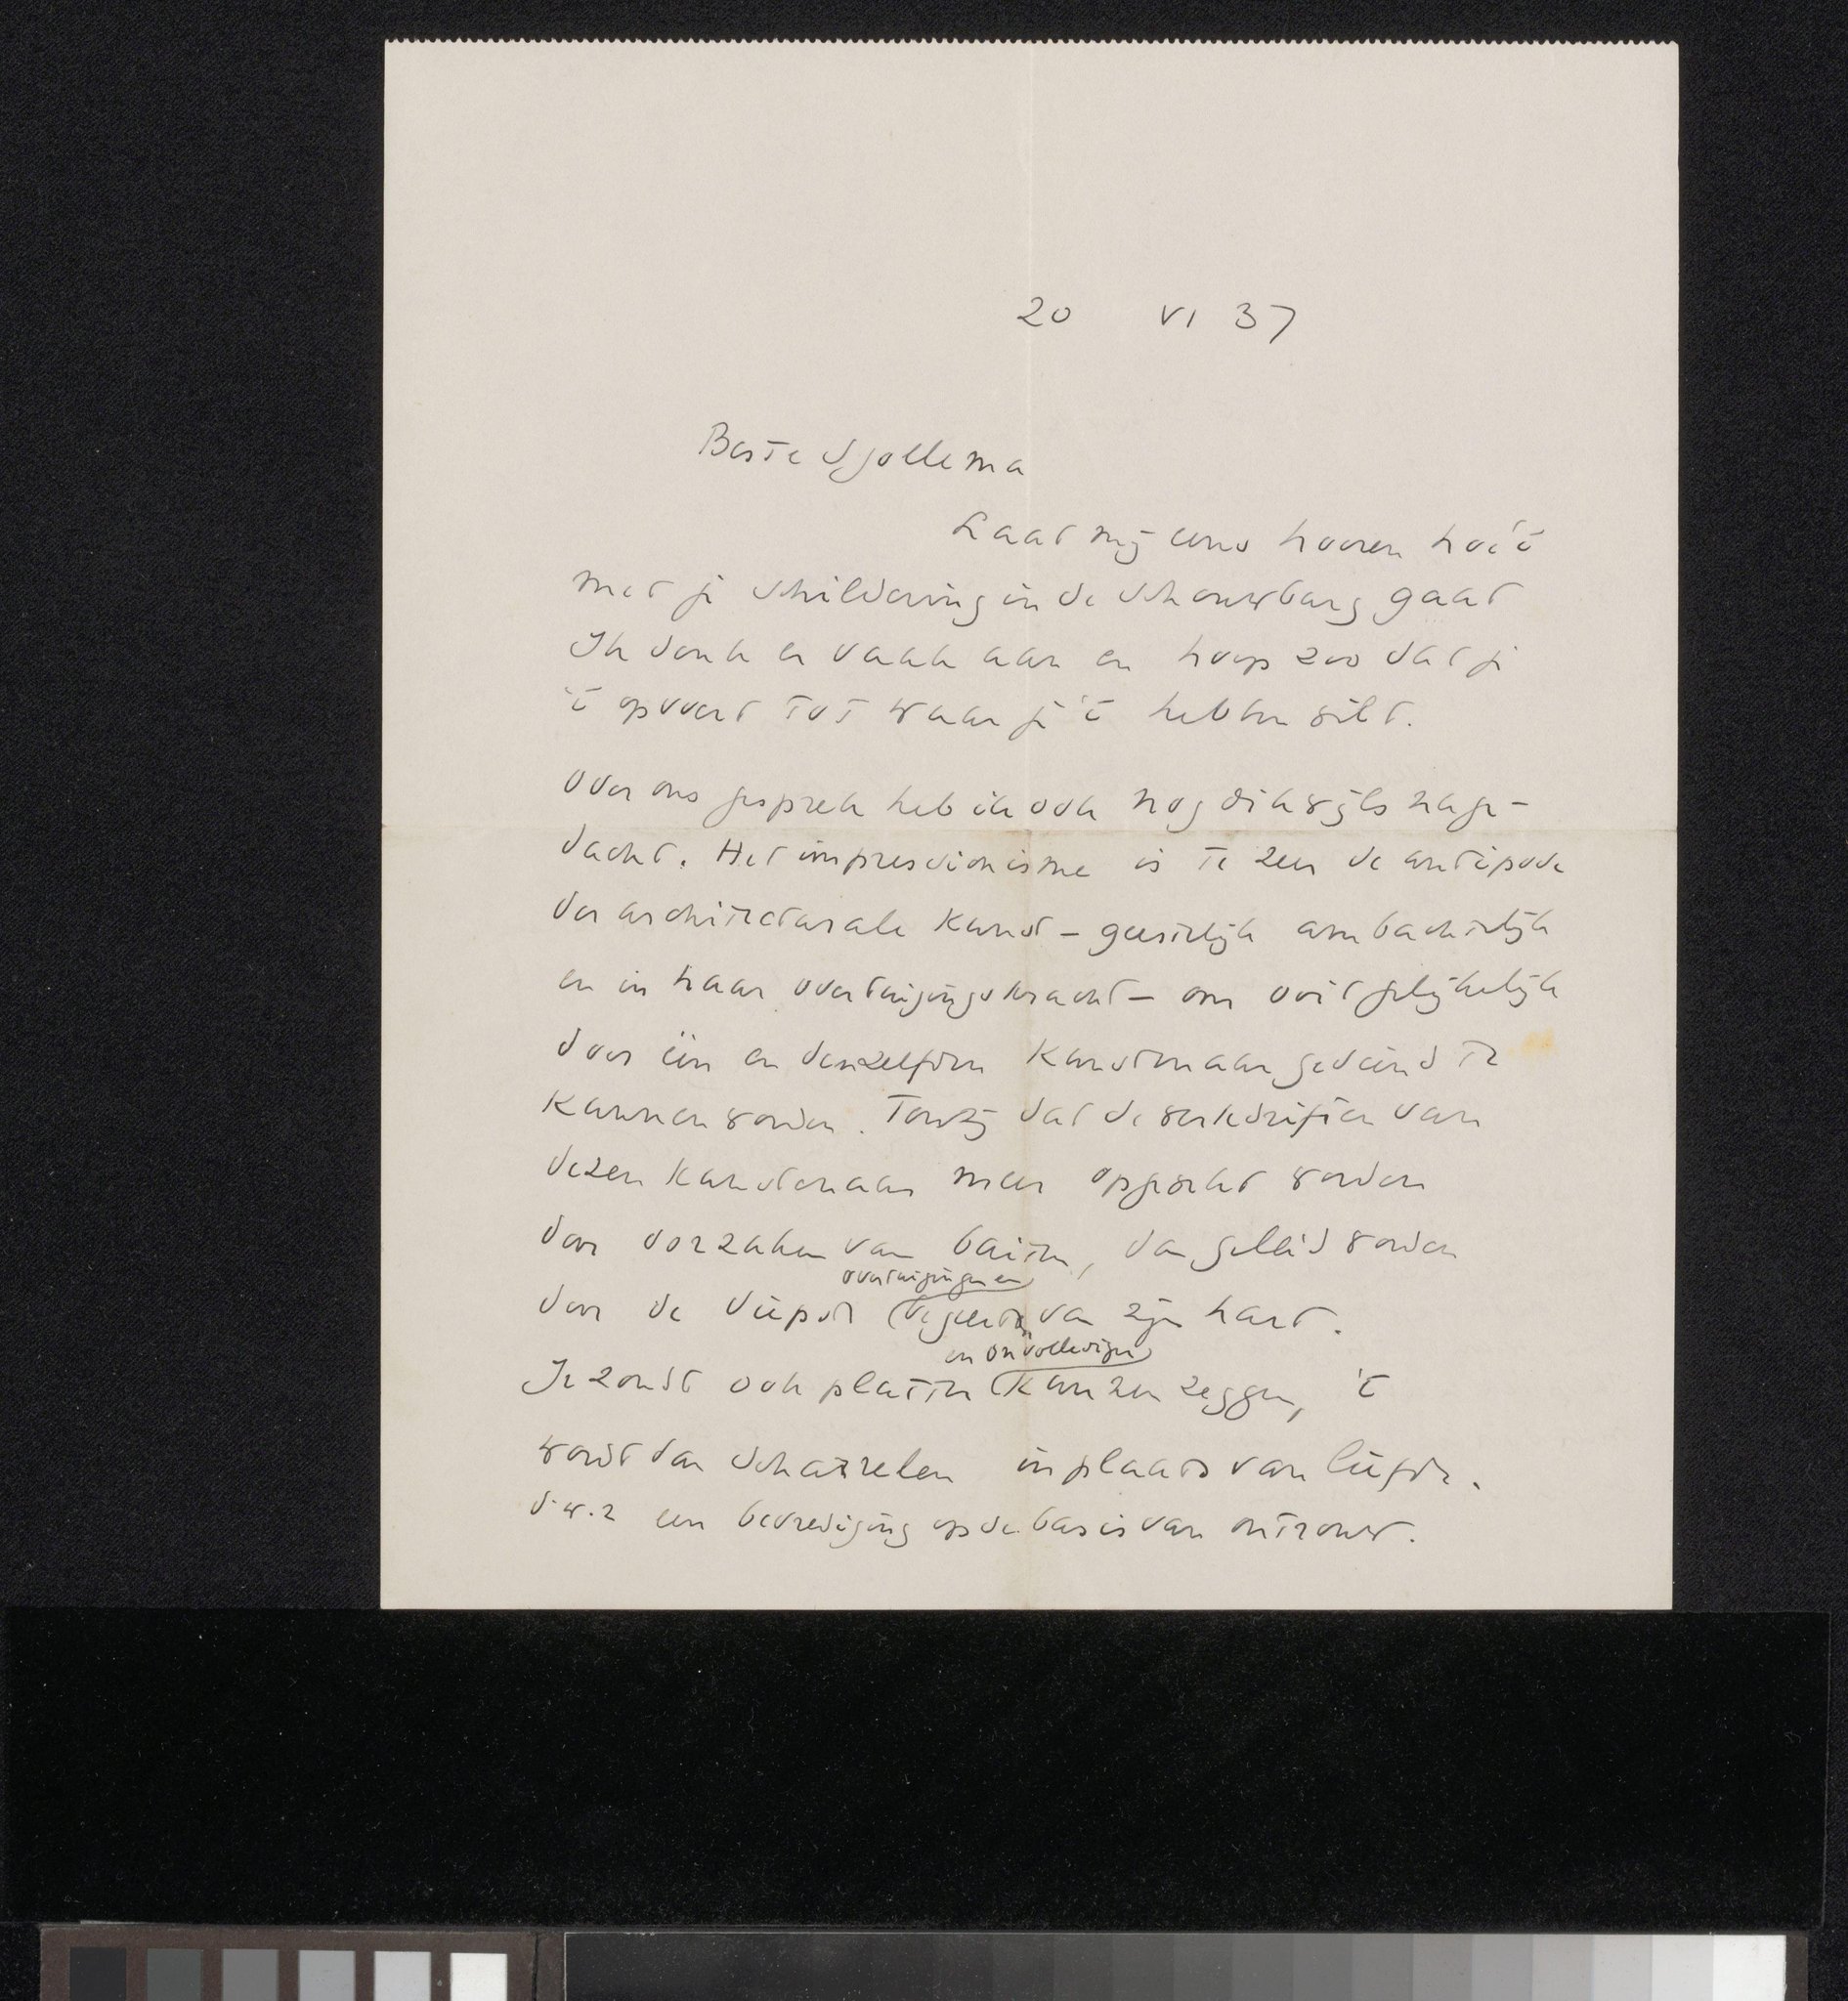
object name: letter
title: Brief aan Joop Sjollema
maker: richard nicolaüs roland holst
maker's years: 1868-1938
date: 1937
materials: ink, paper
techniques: pen, writing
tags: print maker, joop sjollema, charles eyck, fik abbing, draughtsman, joep nicolas, the monumental arts, exhibition ~ art, paris